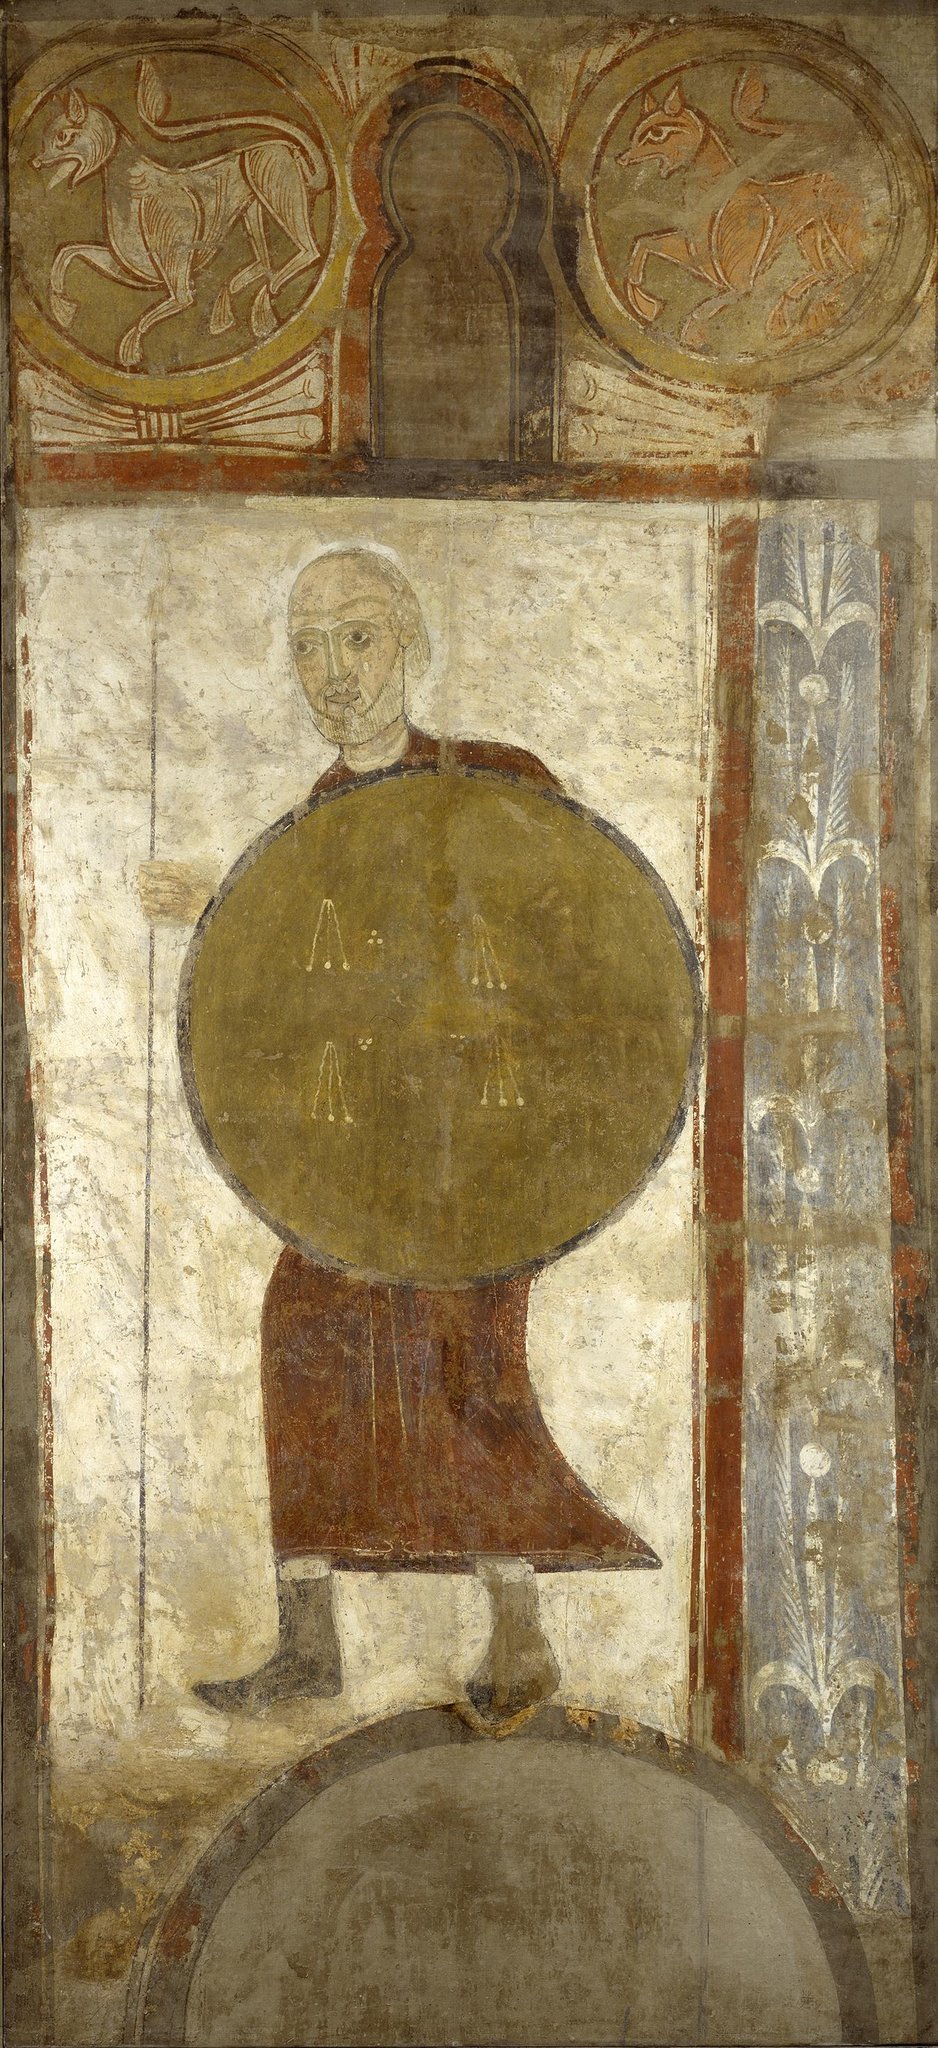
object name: fresco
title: Warrior with Shield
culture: spanish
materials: canvas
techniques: fresco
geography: spain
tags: animals,shields,men